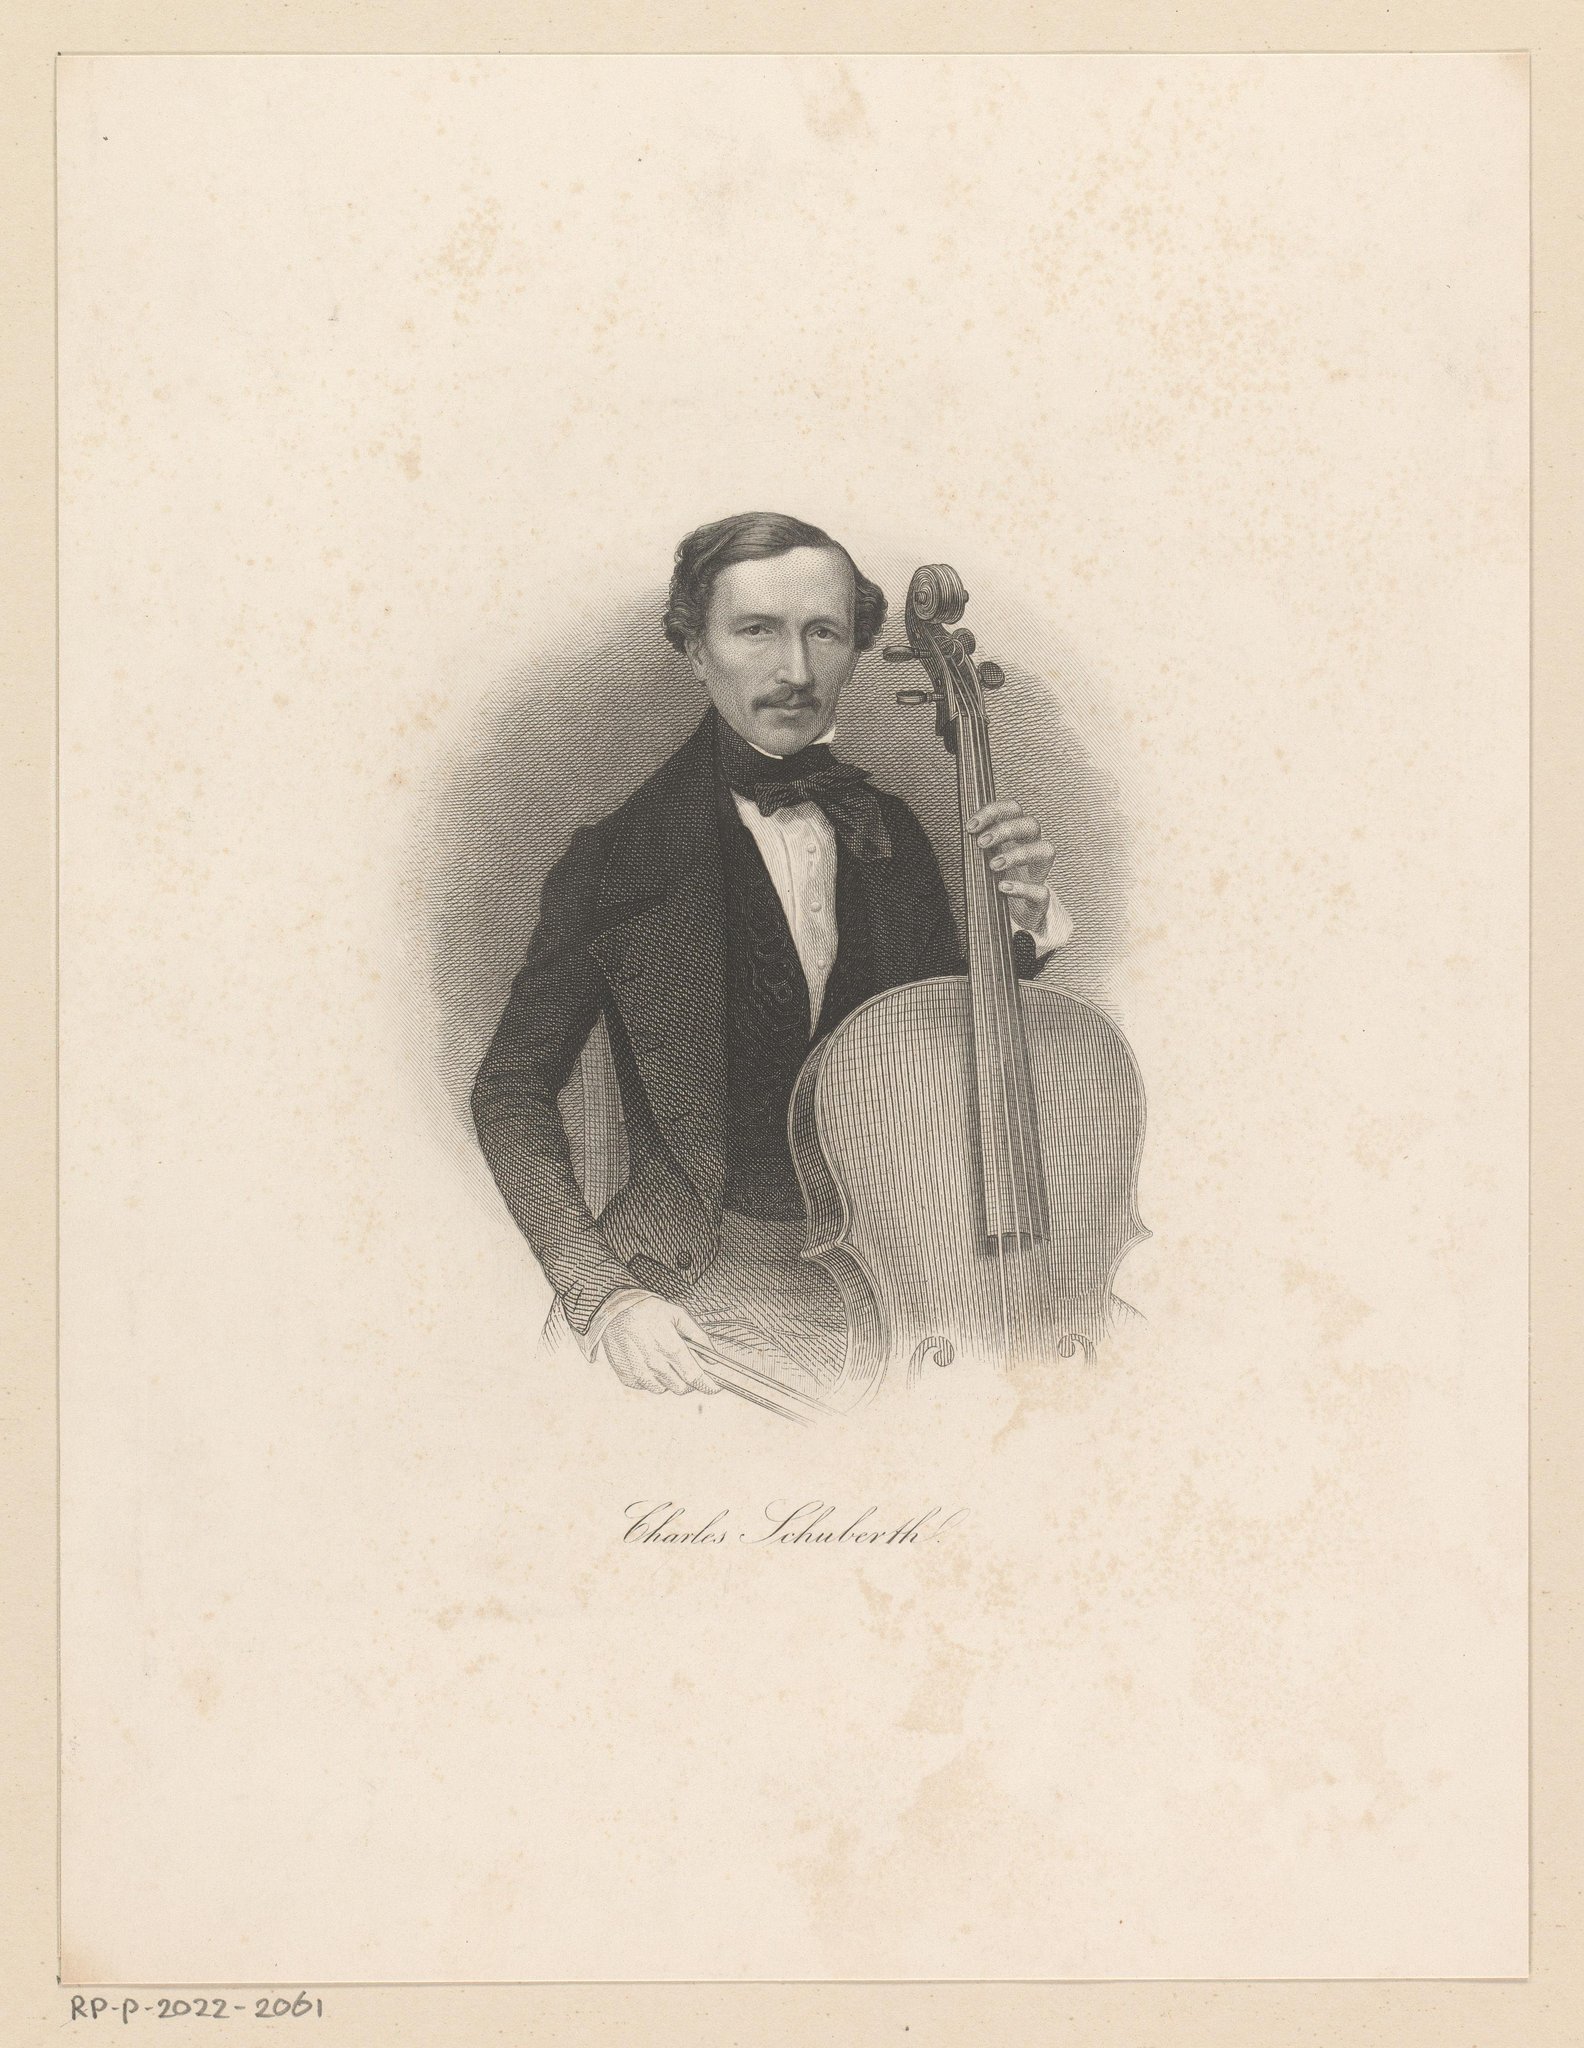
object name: print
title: Charles Schuberth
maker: Anonymous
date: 1841-1899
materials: paper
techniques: engraving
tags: historical persons, portrait of composer